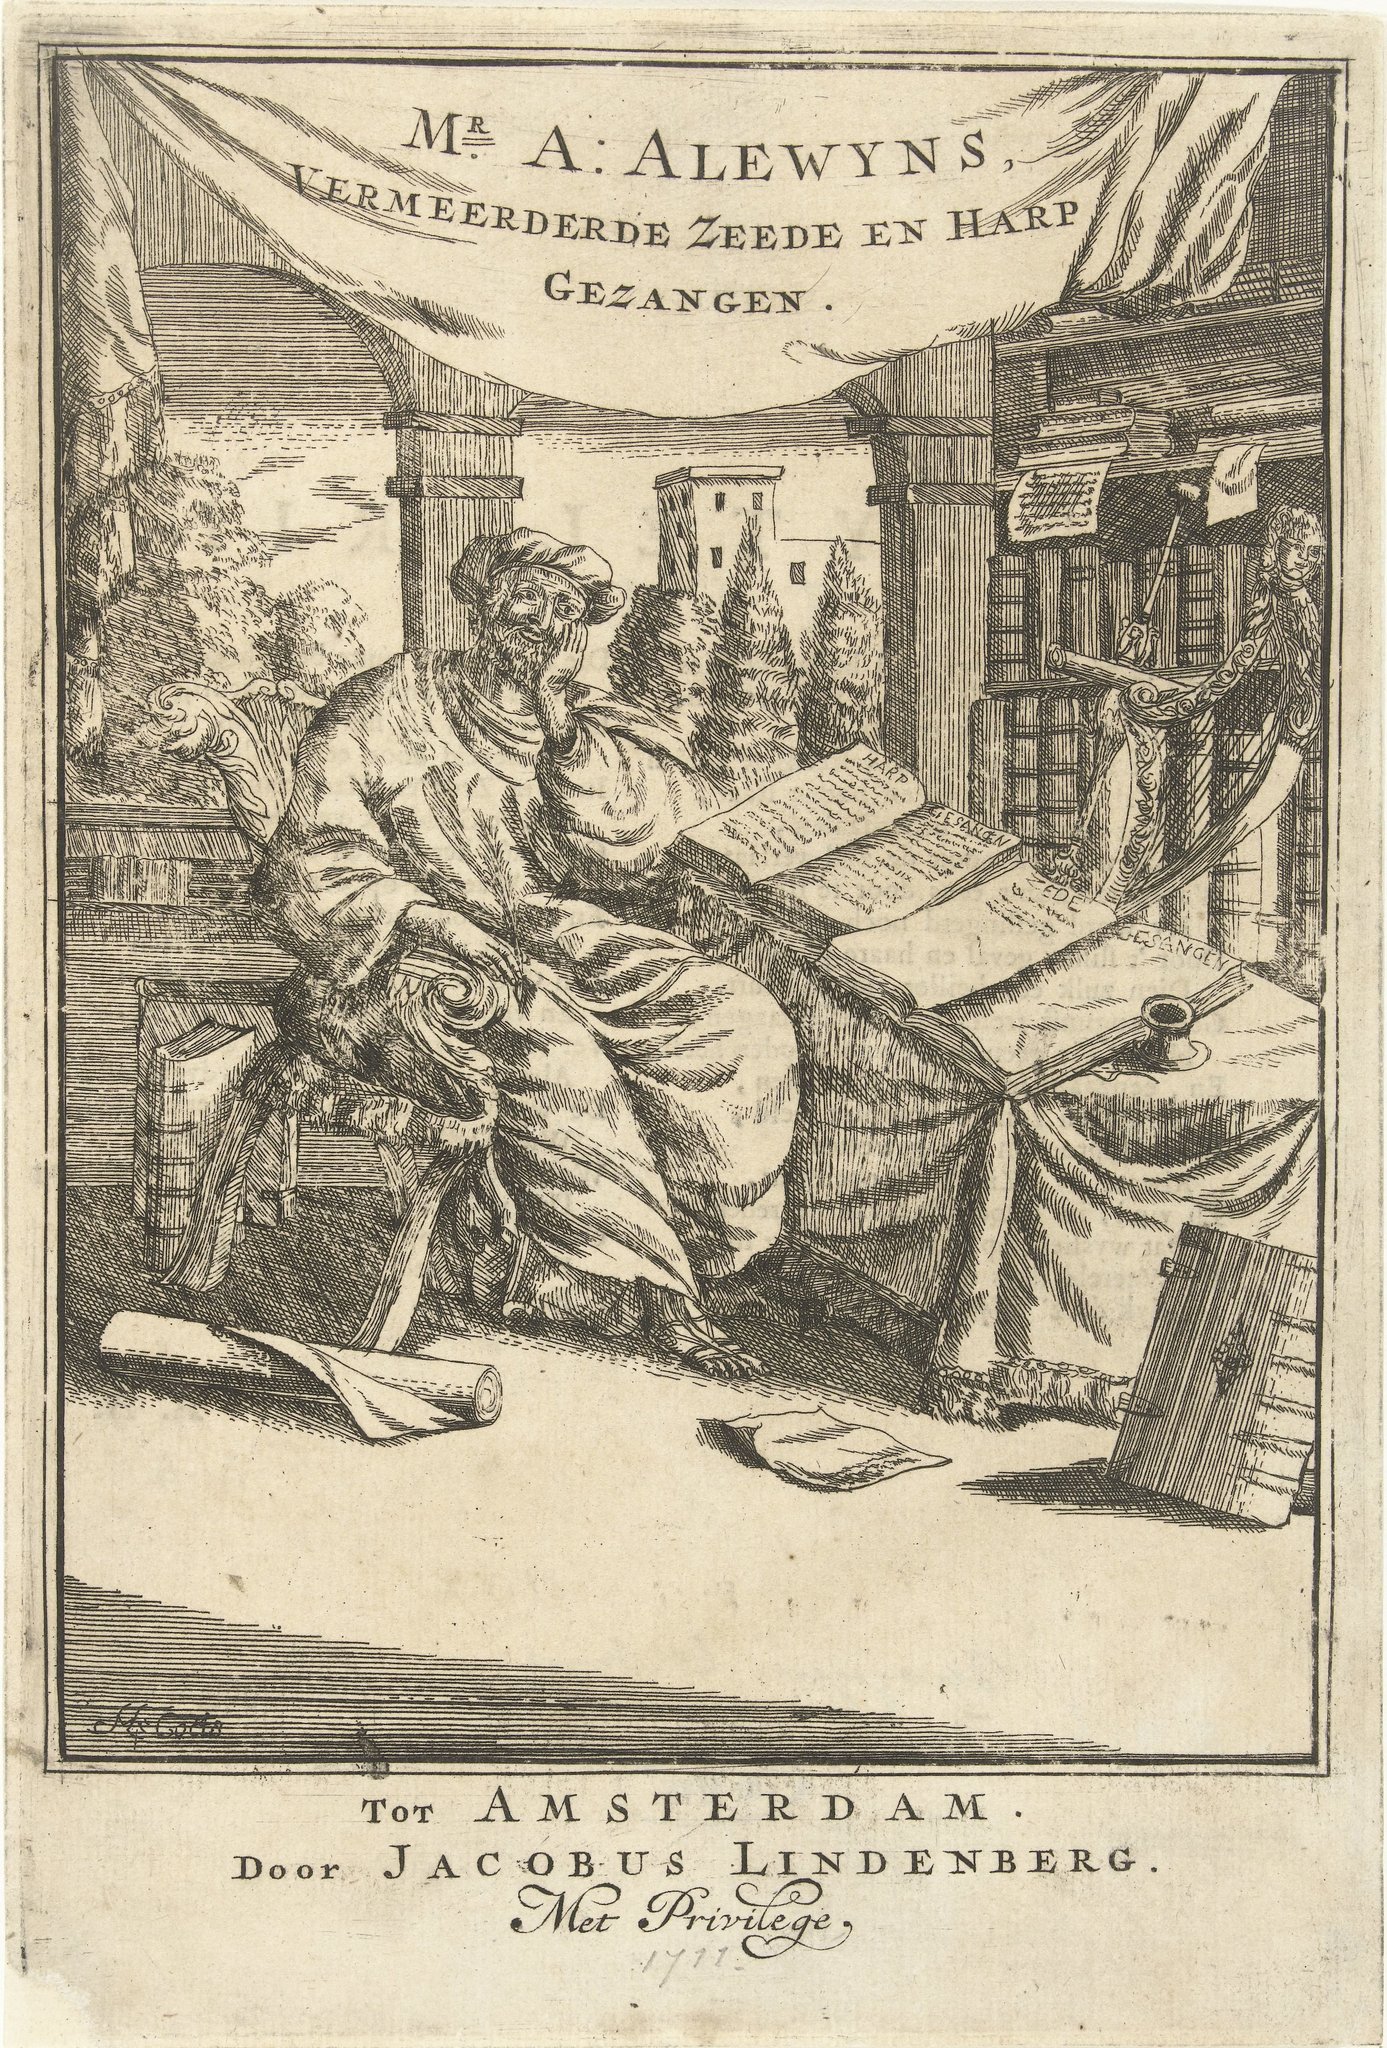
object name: titelblad, titelpagina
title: Dichter aan het werk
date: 1694-1715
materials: paper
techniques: etching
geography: amsterdam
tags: bard, lyric poet (+ artist at work)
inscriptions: collector's mark: Lugt 2228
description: Een dichter is bezig met het schrijven van de zede- en harpgezangen. Voor hem op tafel liggen twee open boeken, in zijn hand houdt hij een schrijfveer. Tegen de boekenkast leunt een harp.